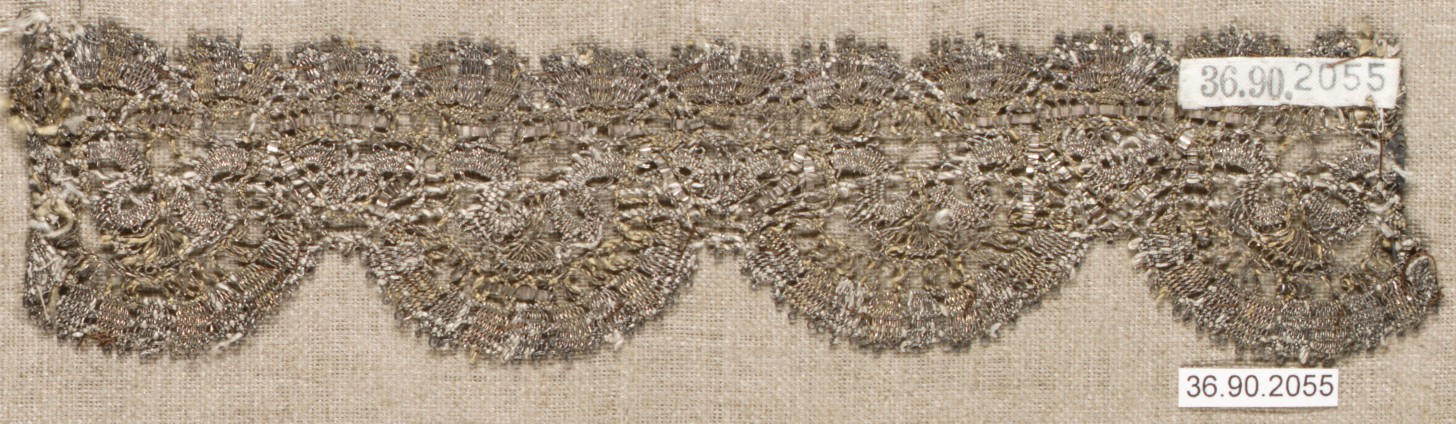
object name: galloon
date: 1801-1900